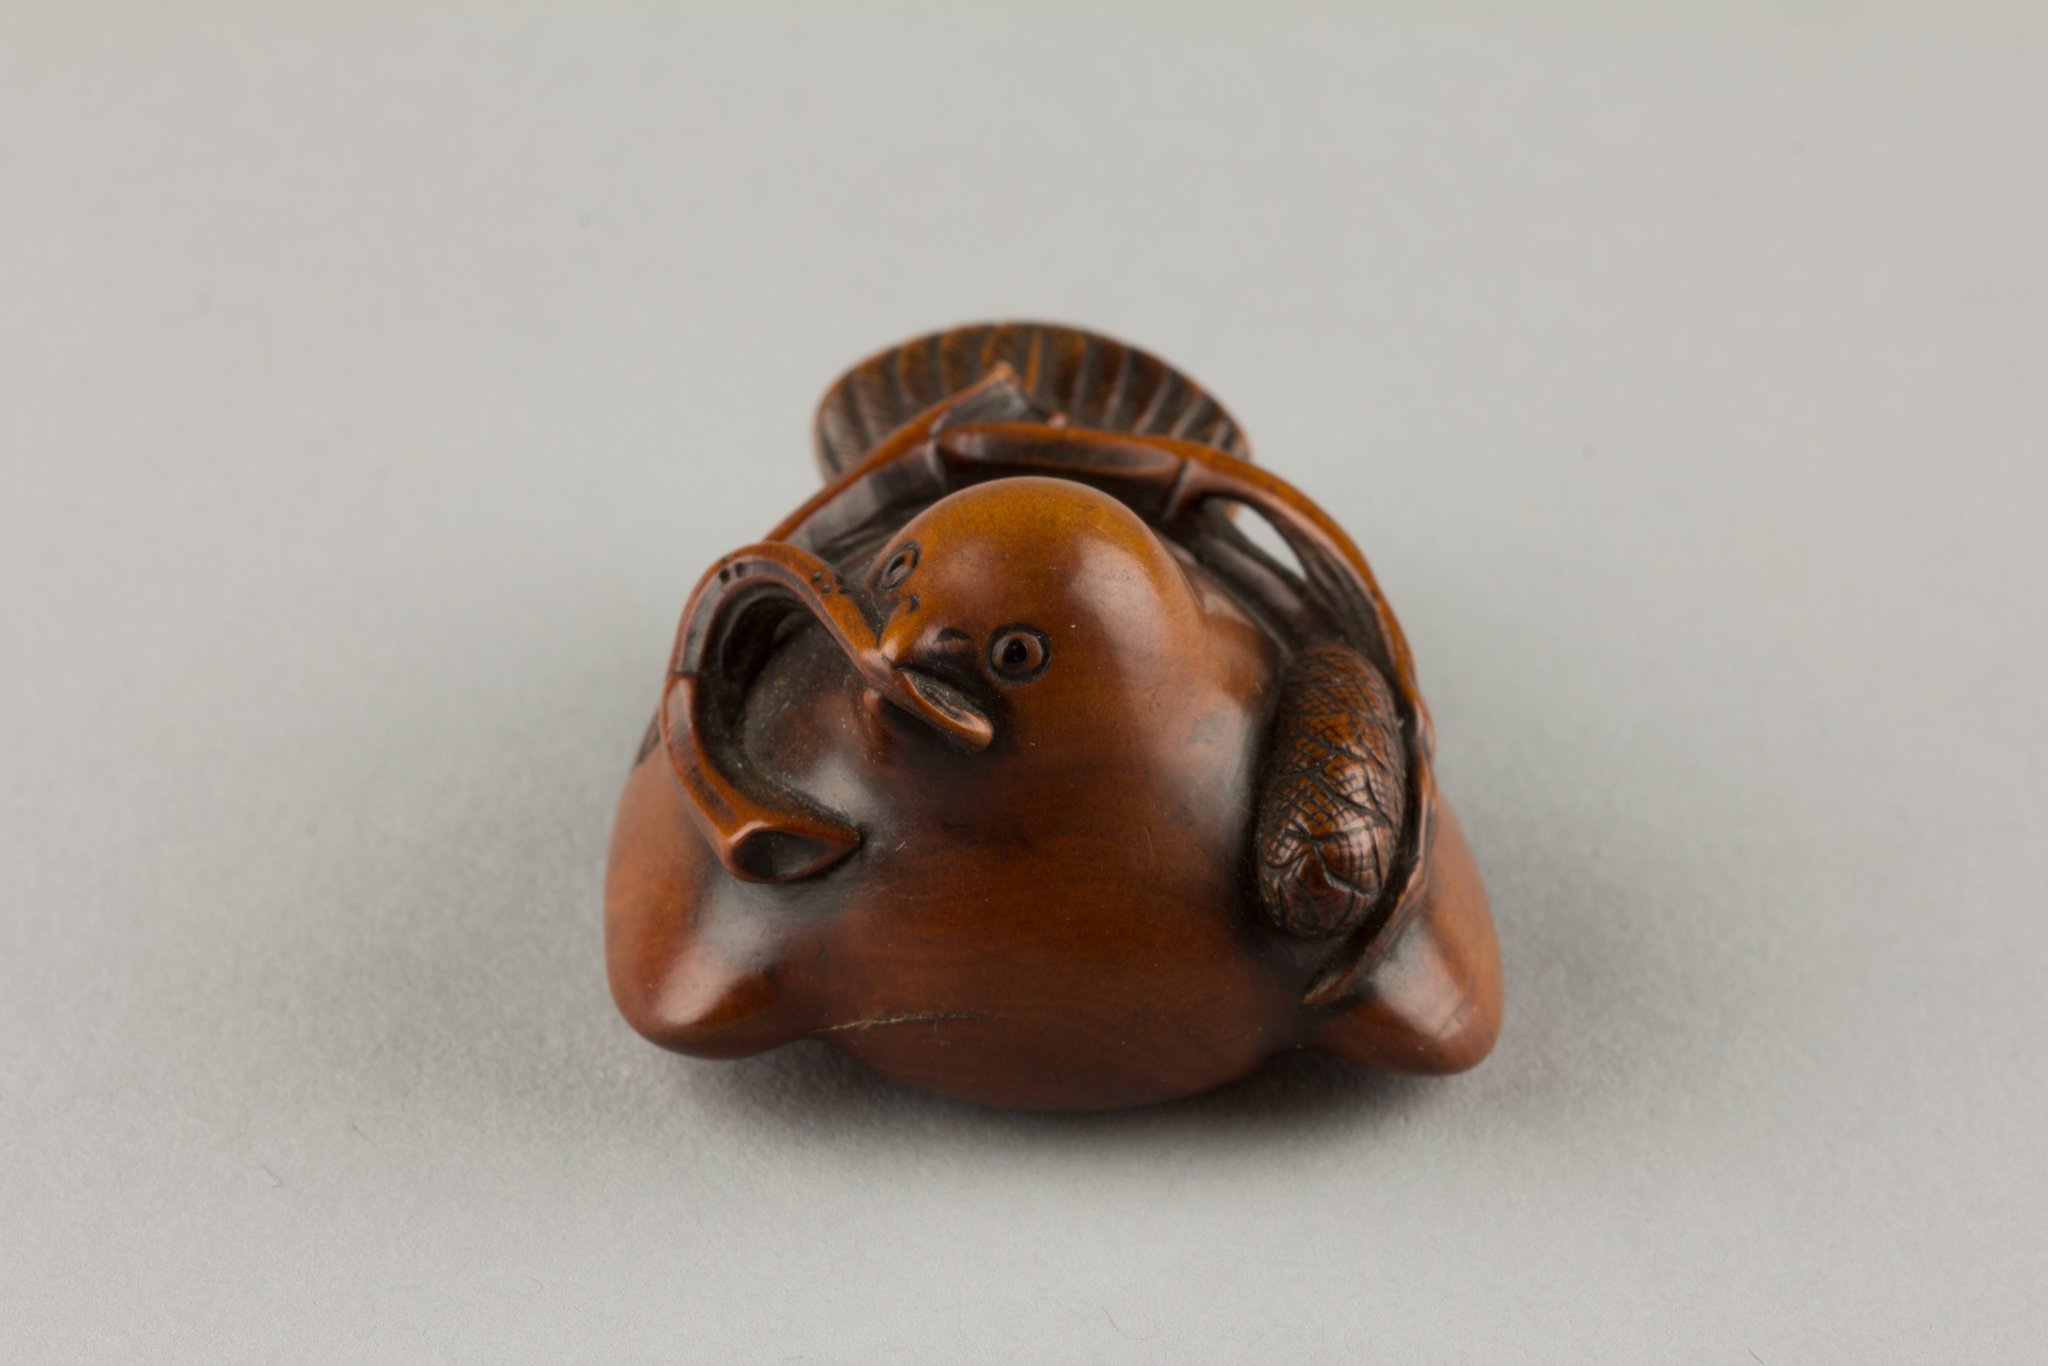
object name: netsuke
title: Netsuke of Sparrow (Split-tongue)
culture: japanese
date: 1801-1900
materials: wood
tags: birds